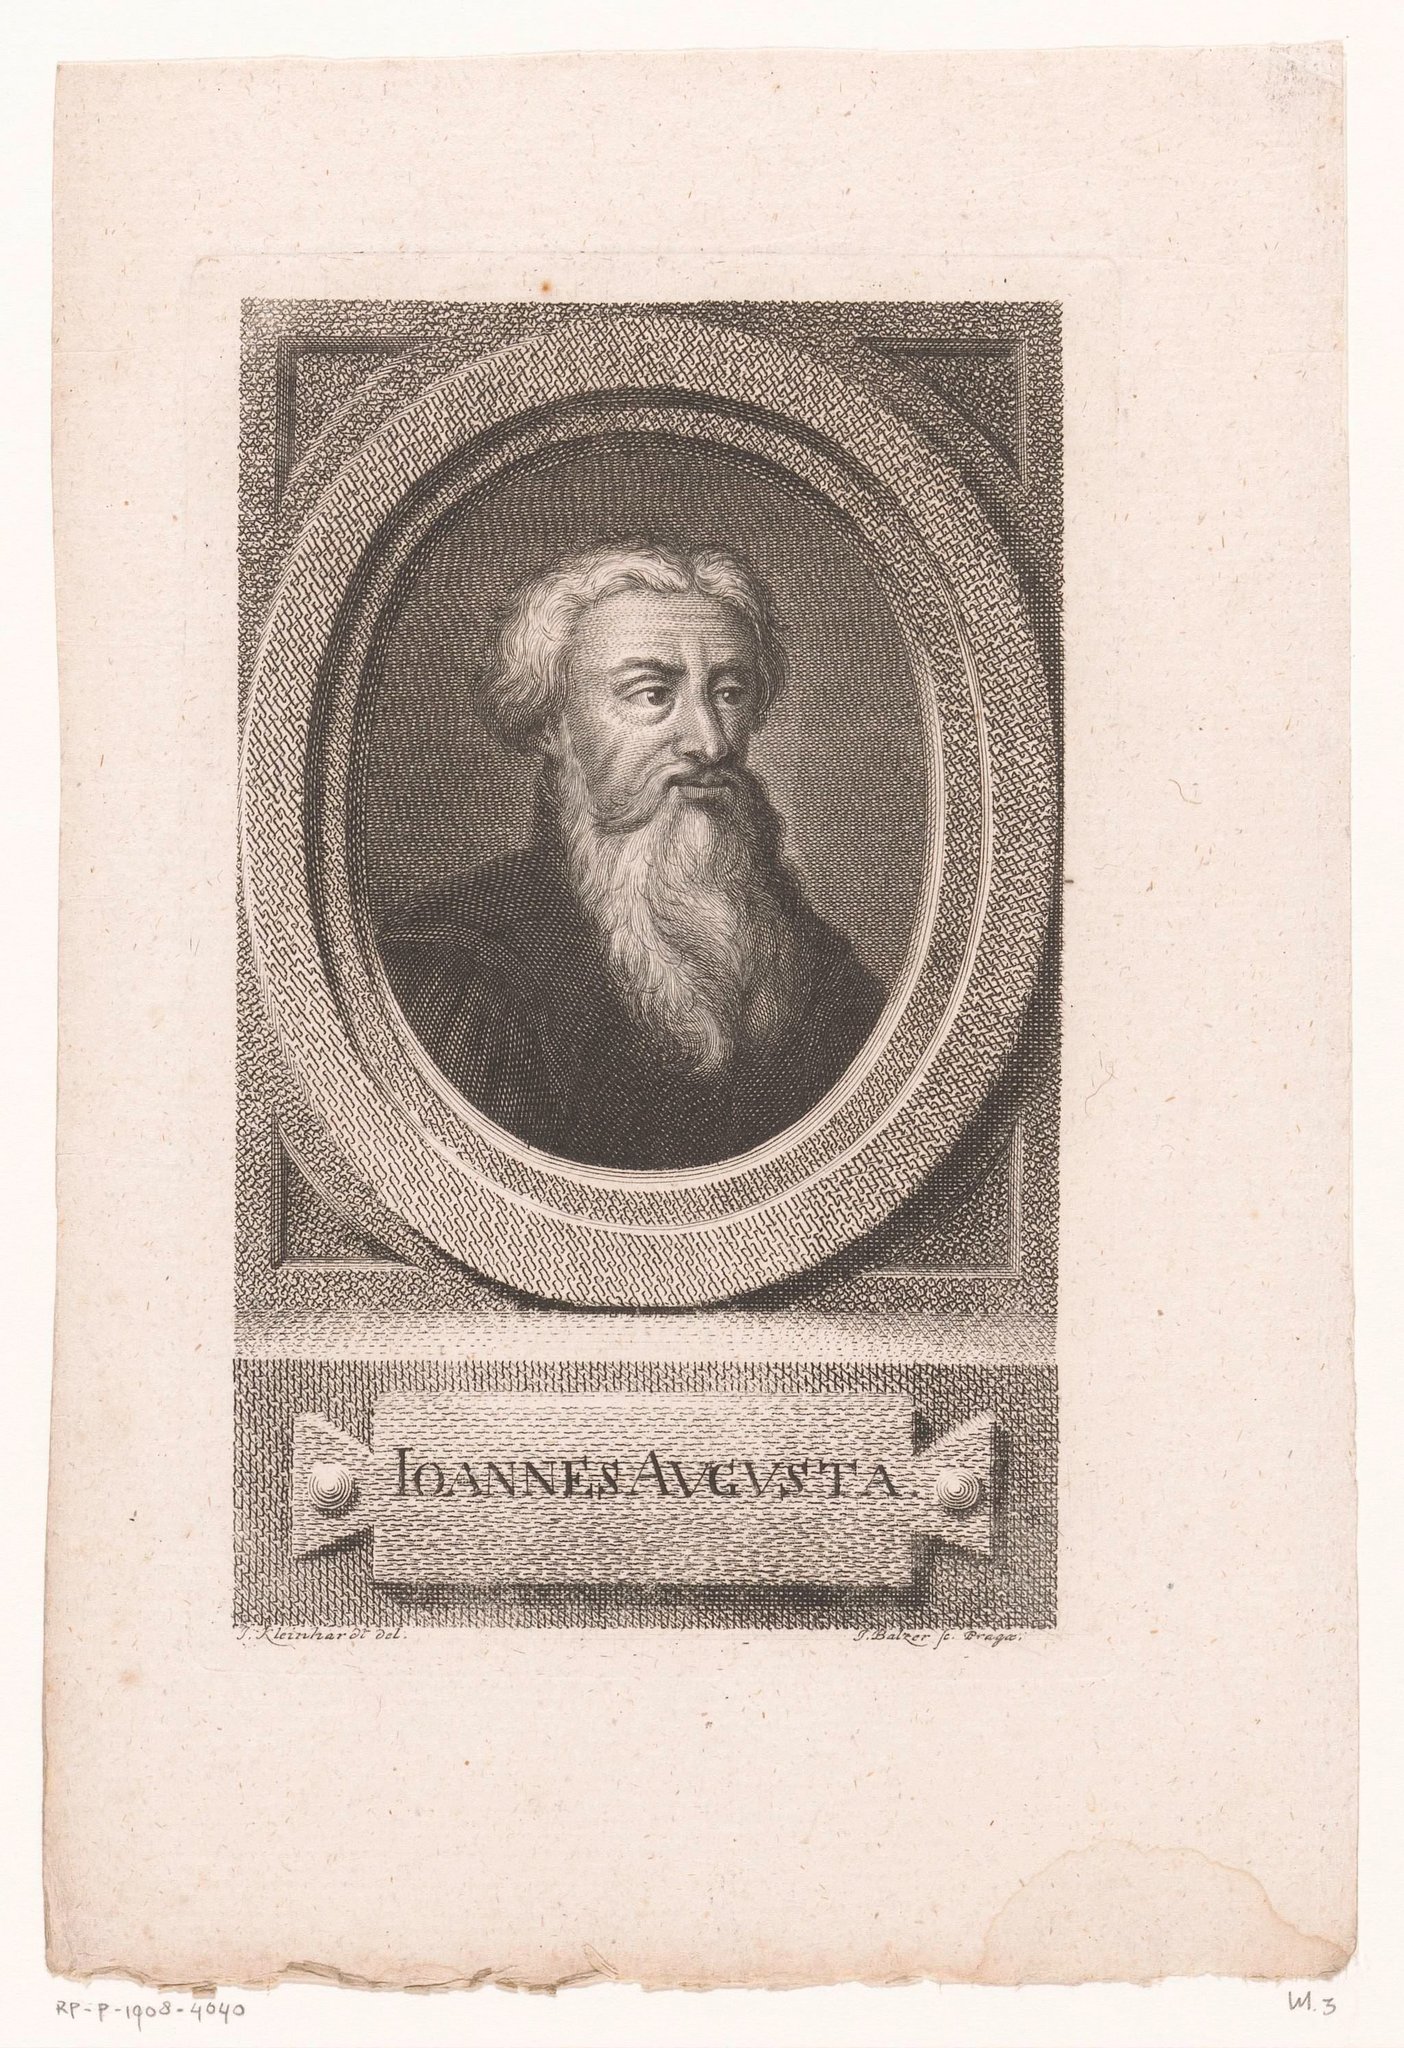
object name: print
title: Portret van Johannes Augusta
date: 1752-1799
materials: paper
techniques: engraving, etching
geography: prague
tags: prague, historical persons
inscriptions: collector's mark: Lugt 2228